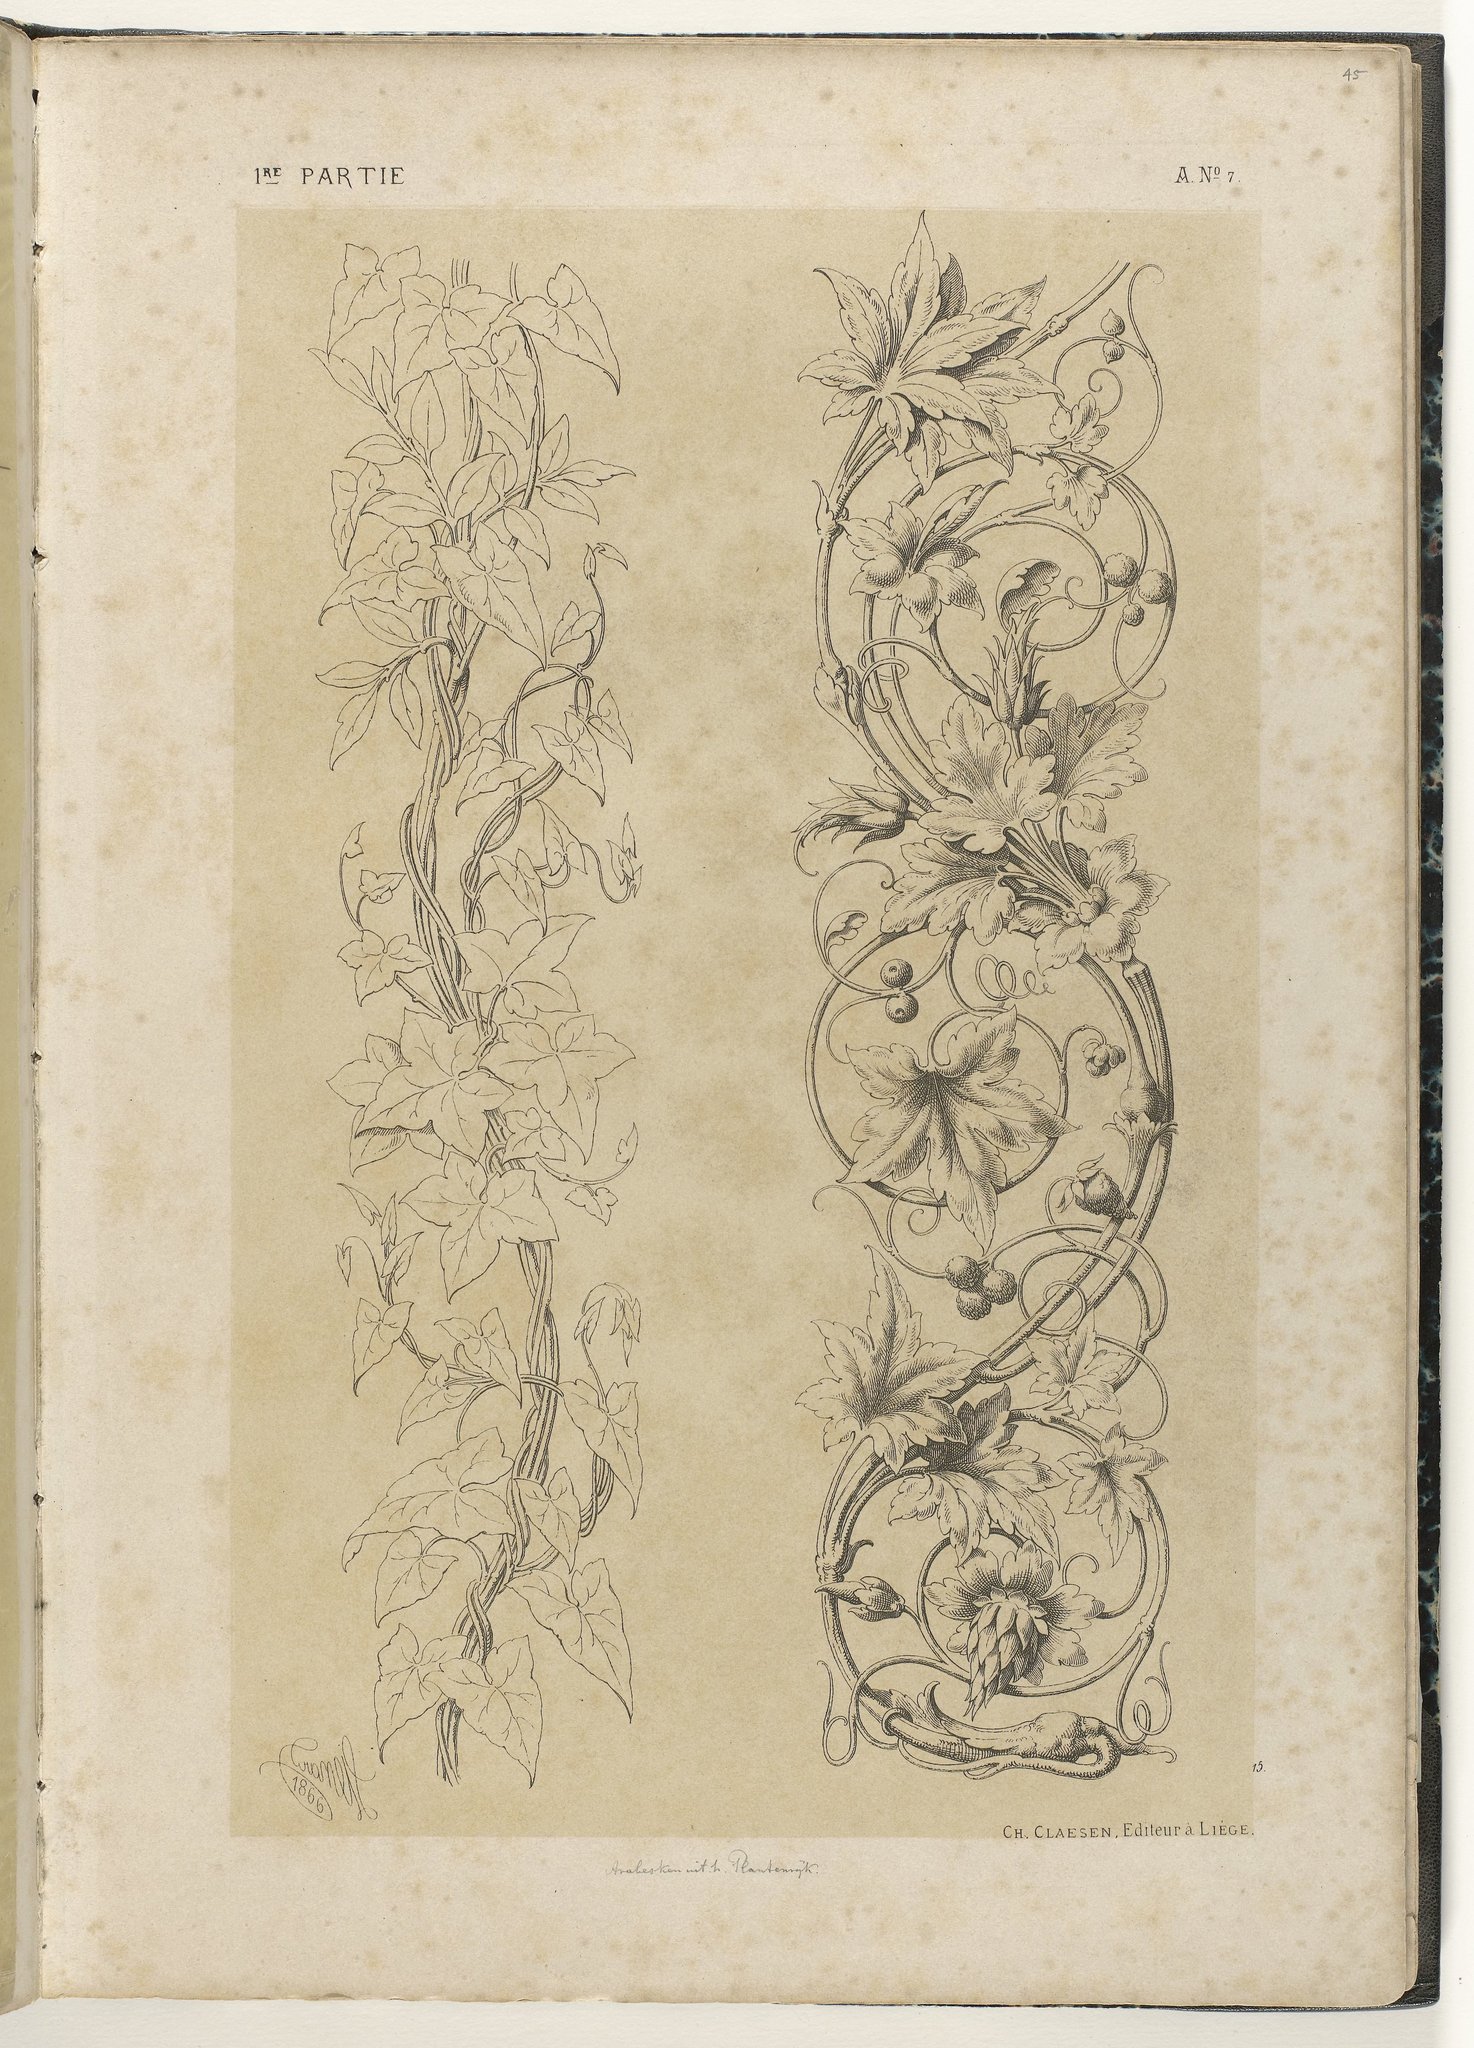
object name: print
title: Twee motieven van bladranken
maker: michel liénard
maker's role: print maker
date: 1866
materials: paper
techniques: tone lithography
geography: liège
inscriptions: annotation: ‘Arabesken uit.h. Plantenrijk.’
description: Linksboven staat gedrukt: 1re partie, rechtsboven: A. N° 7., rechtsonder: 15.